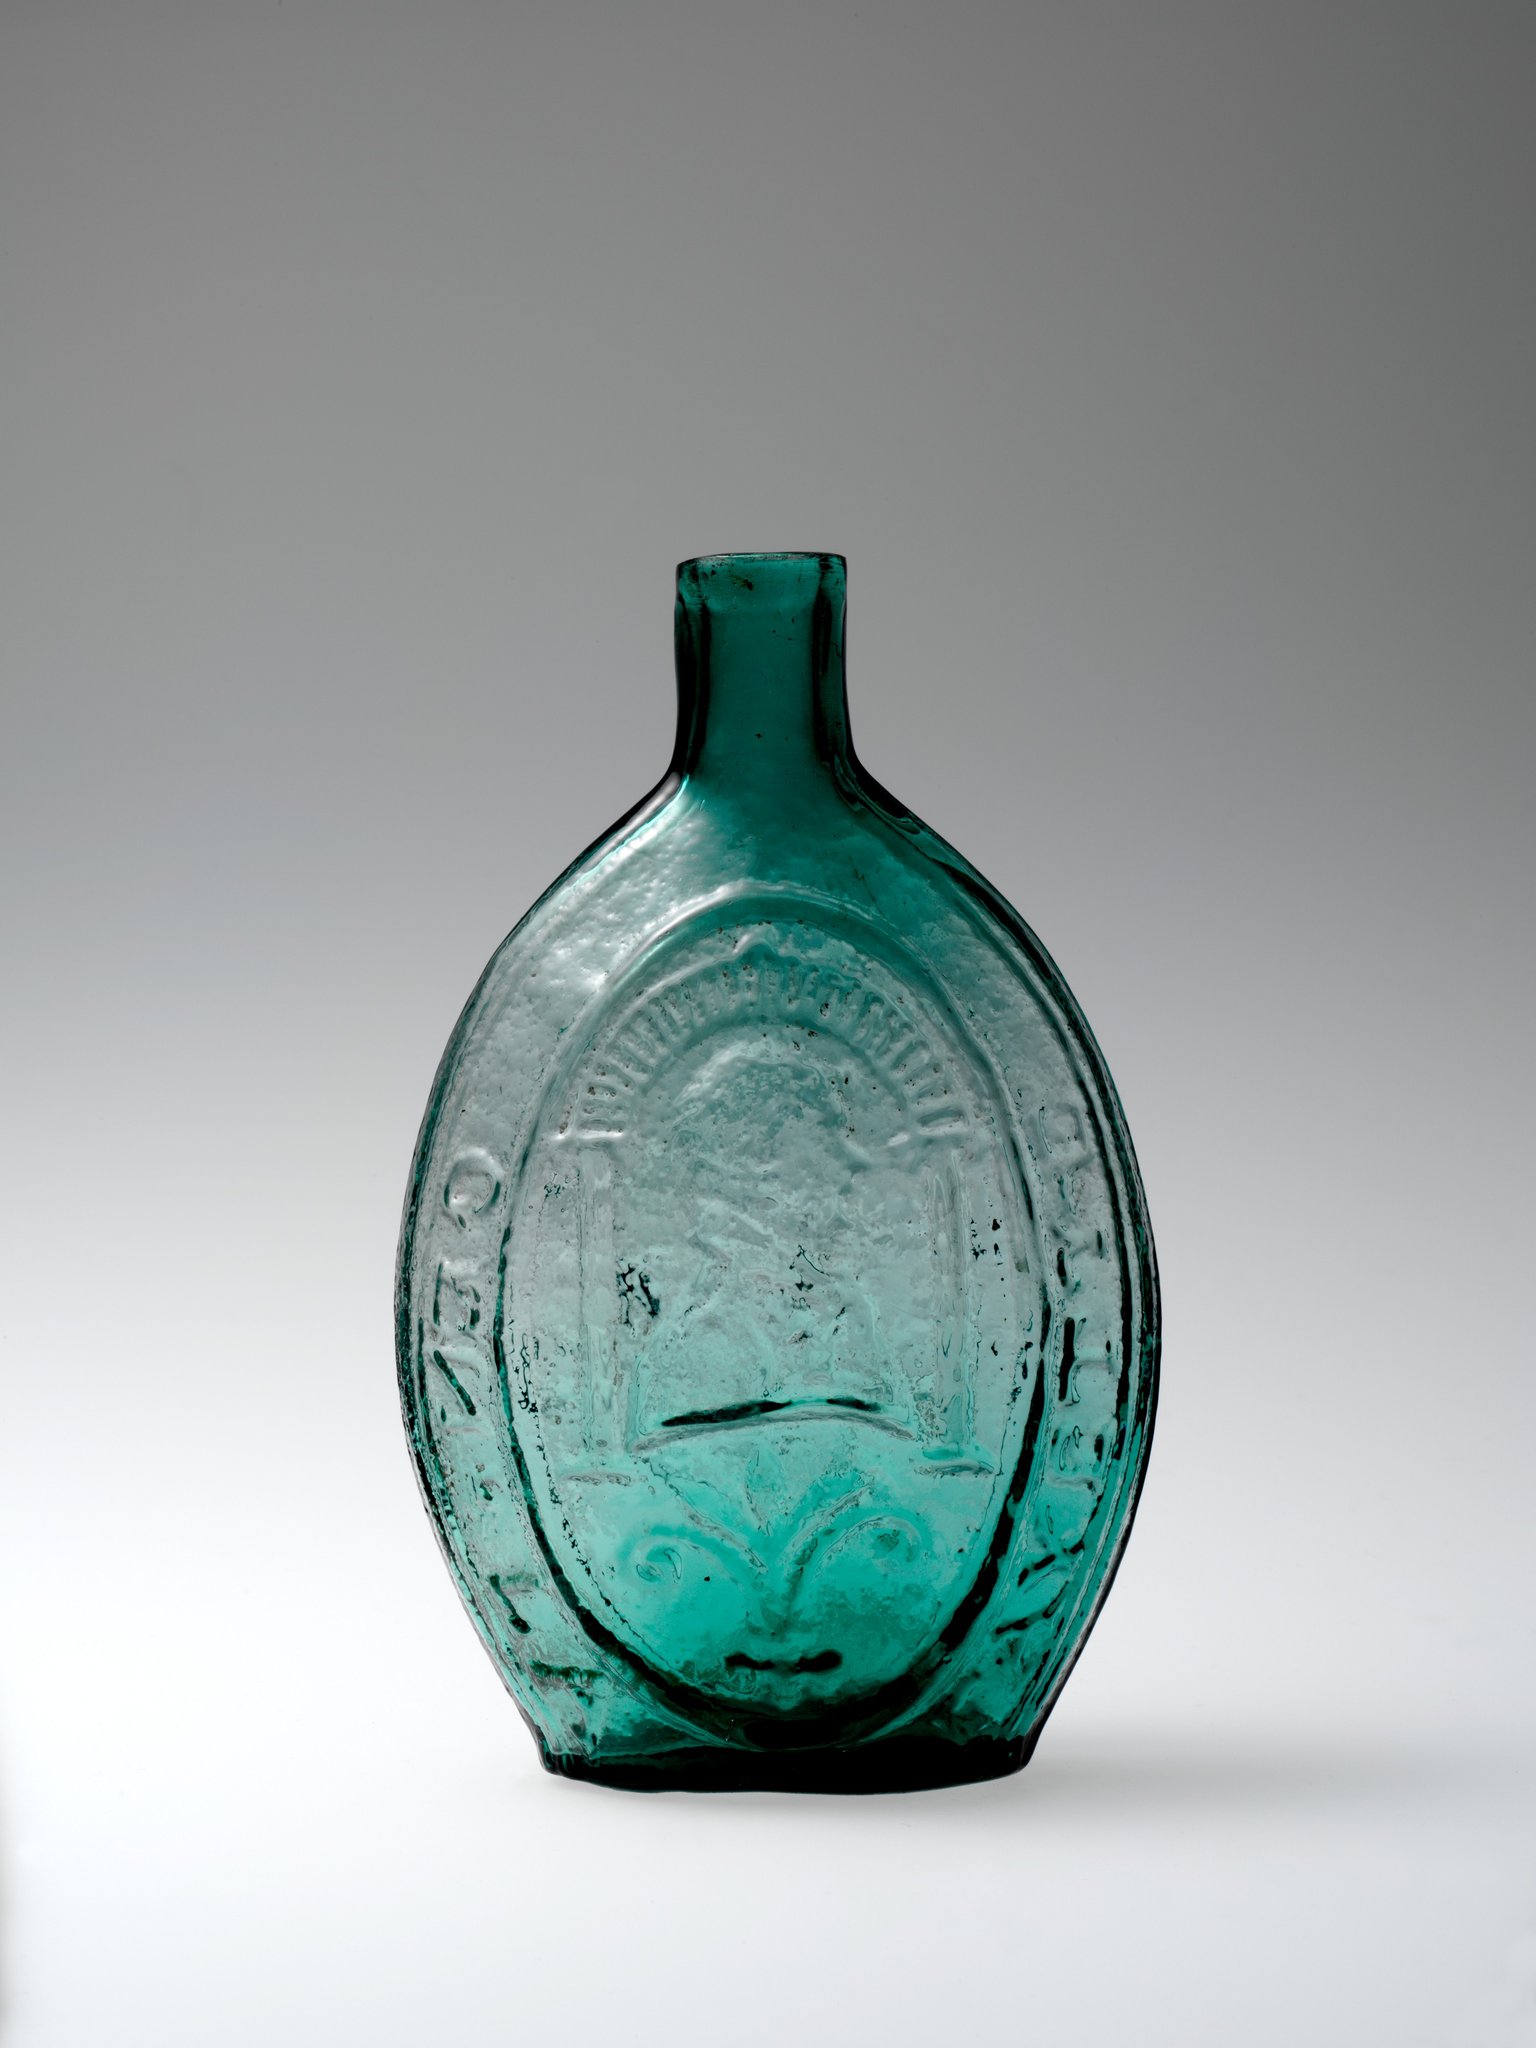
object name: flask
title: Figured flask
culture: american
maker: knox and mckee (virginia green glass works)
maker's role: maker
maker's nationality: american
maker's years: 1820-1833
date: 1824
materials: glass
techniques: glassblowing, molding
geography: united states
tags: men,marquis de lafayette